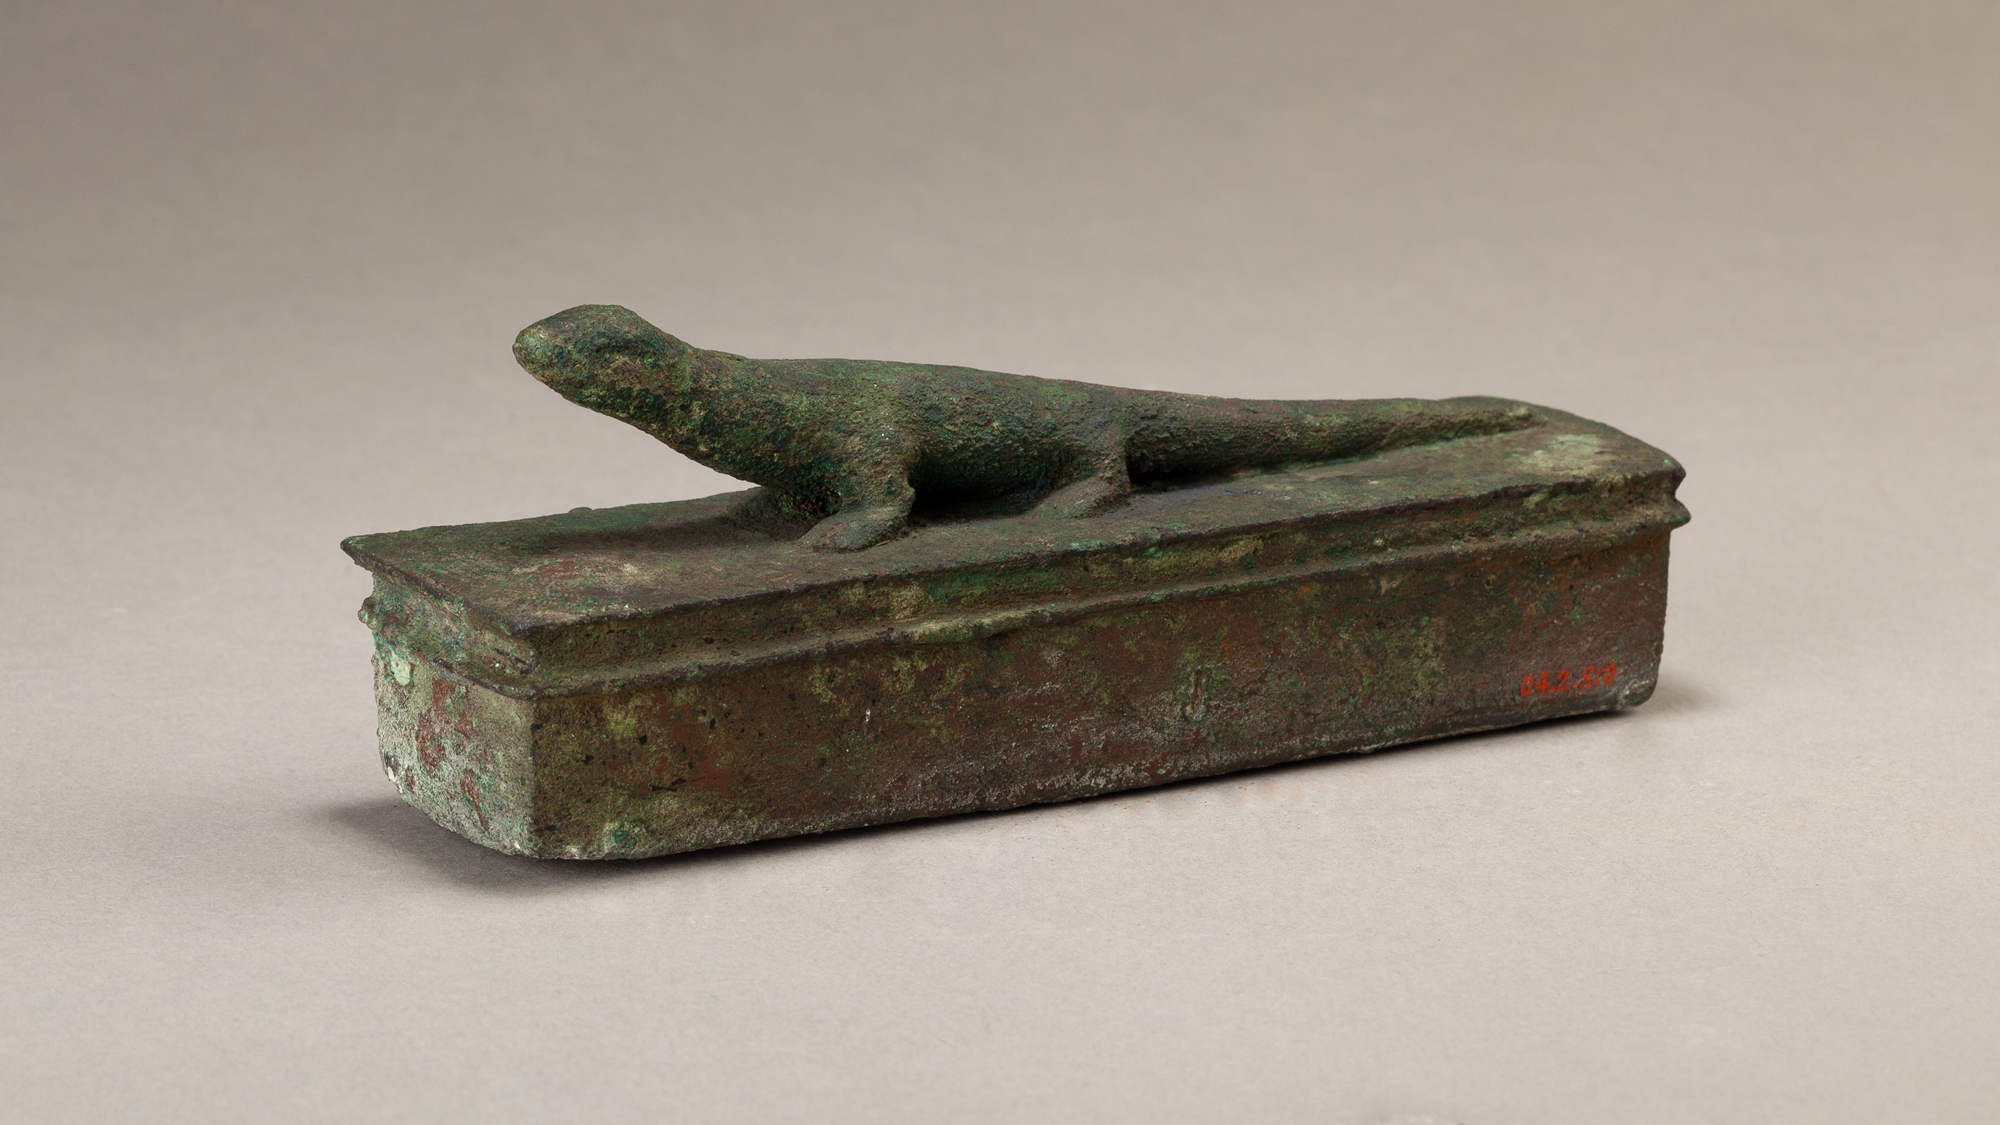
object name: animal mummy case, shrine shaped, lizard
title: Shrine-shaped case for an animal mummy surmounted by a lizard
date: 664-630 BCE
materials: metal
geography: egypt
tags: lizards